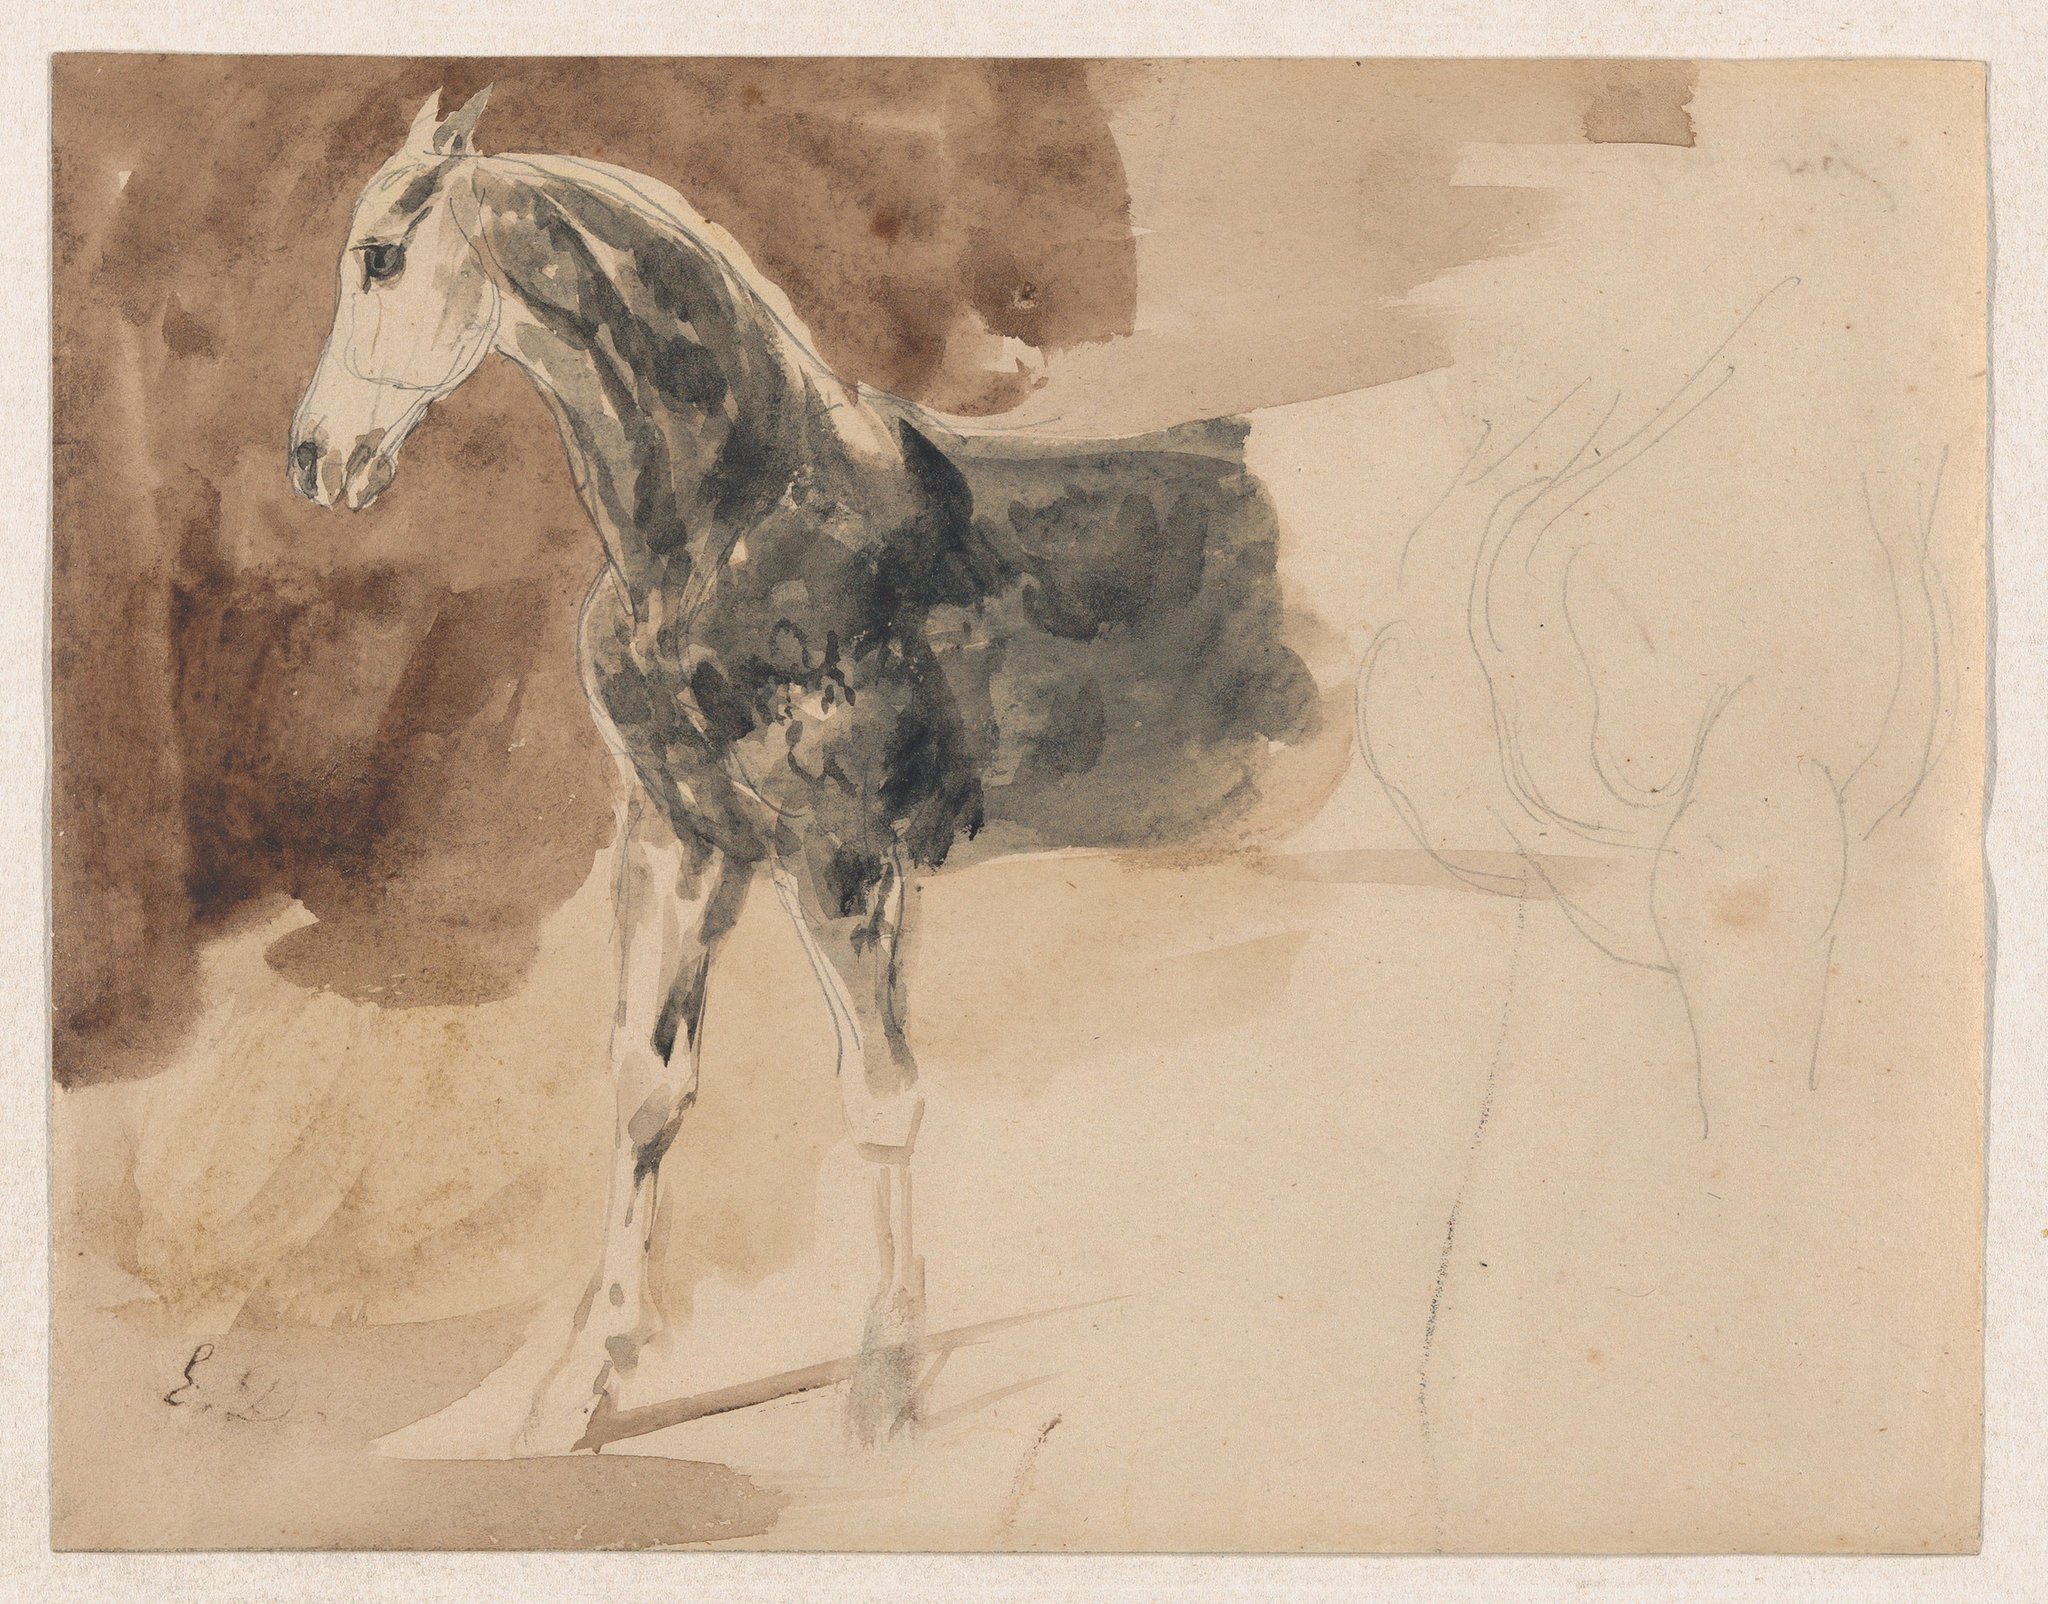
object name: drawing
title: Study of a Horse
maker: eugène delacroix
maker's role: artist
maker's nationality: french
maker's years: 1798-1863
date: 1824-1829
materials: graphite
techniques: brush, wash